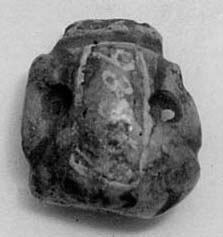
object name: pendant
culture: guatemala or mexico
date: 1902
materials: jade